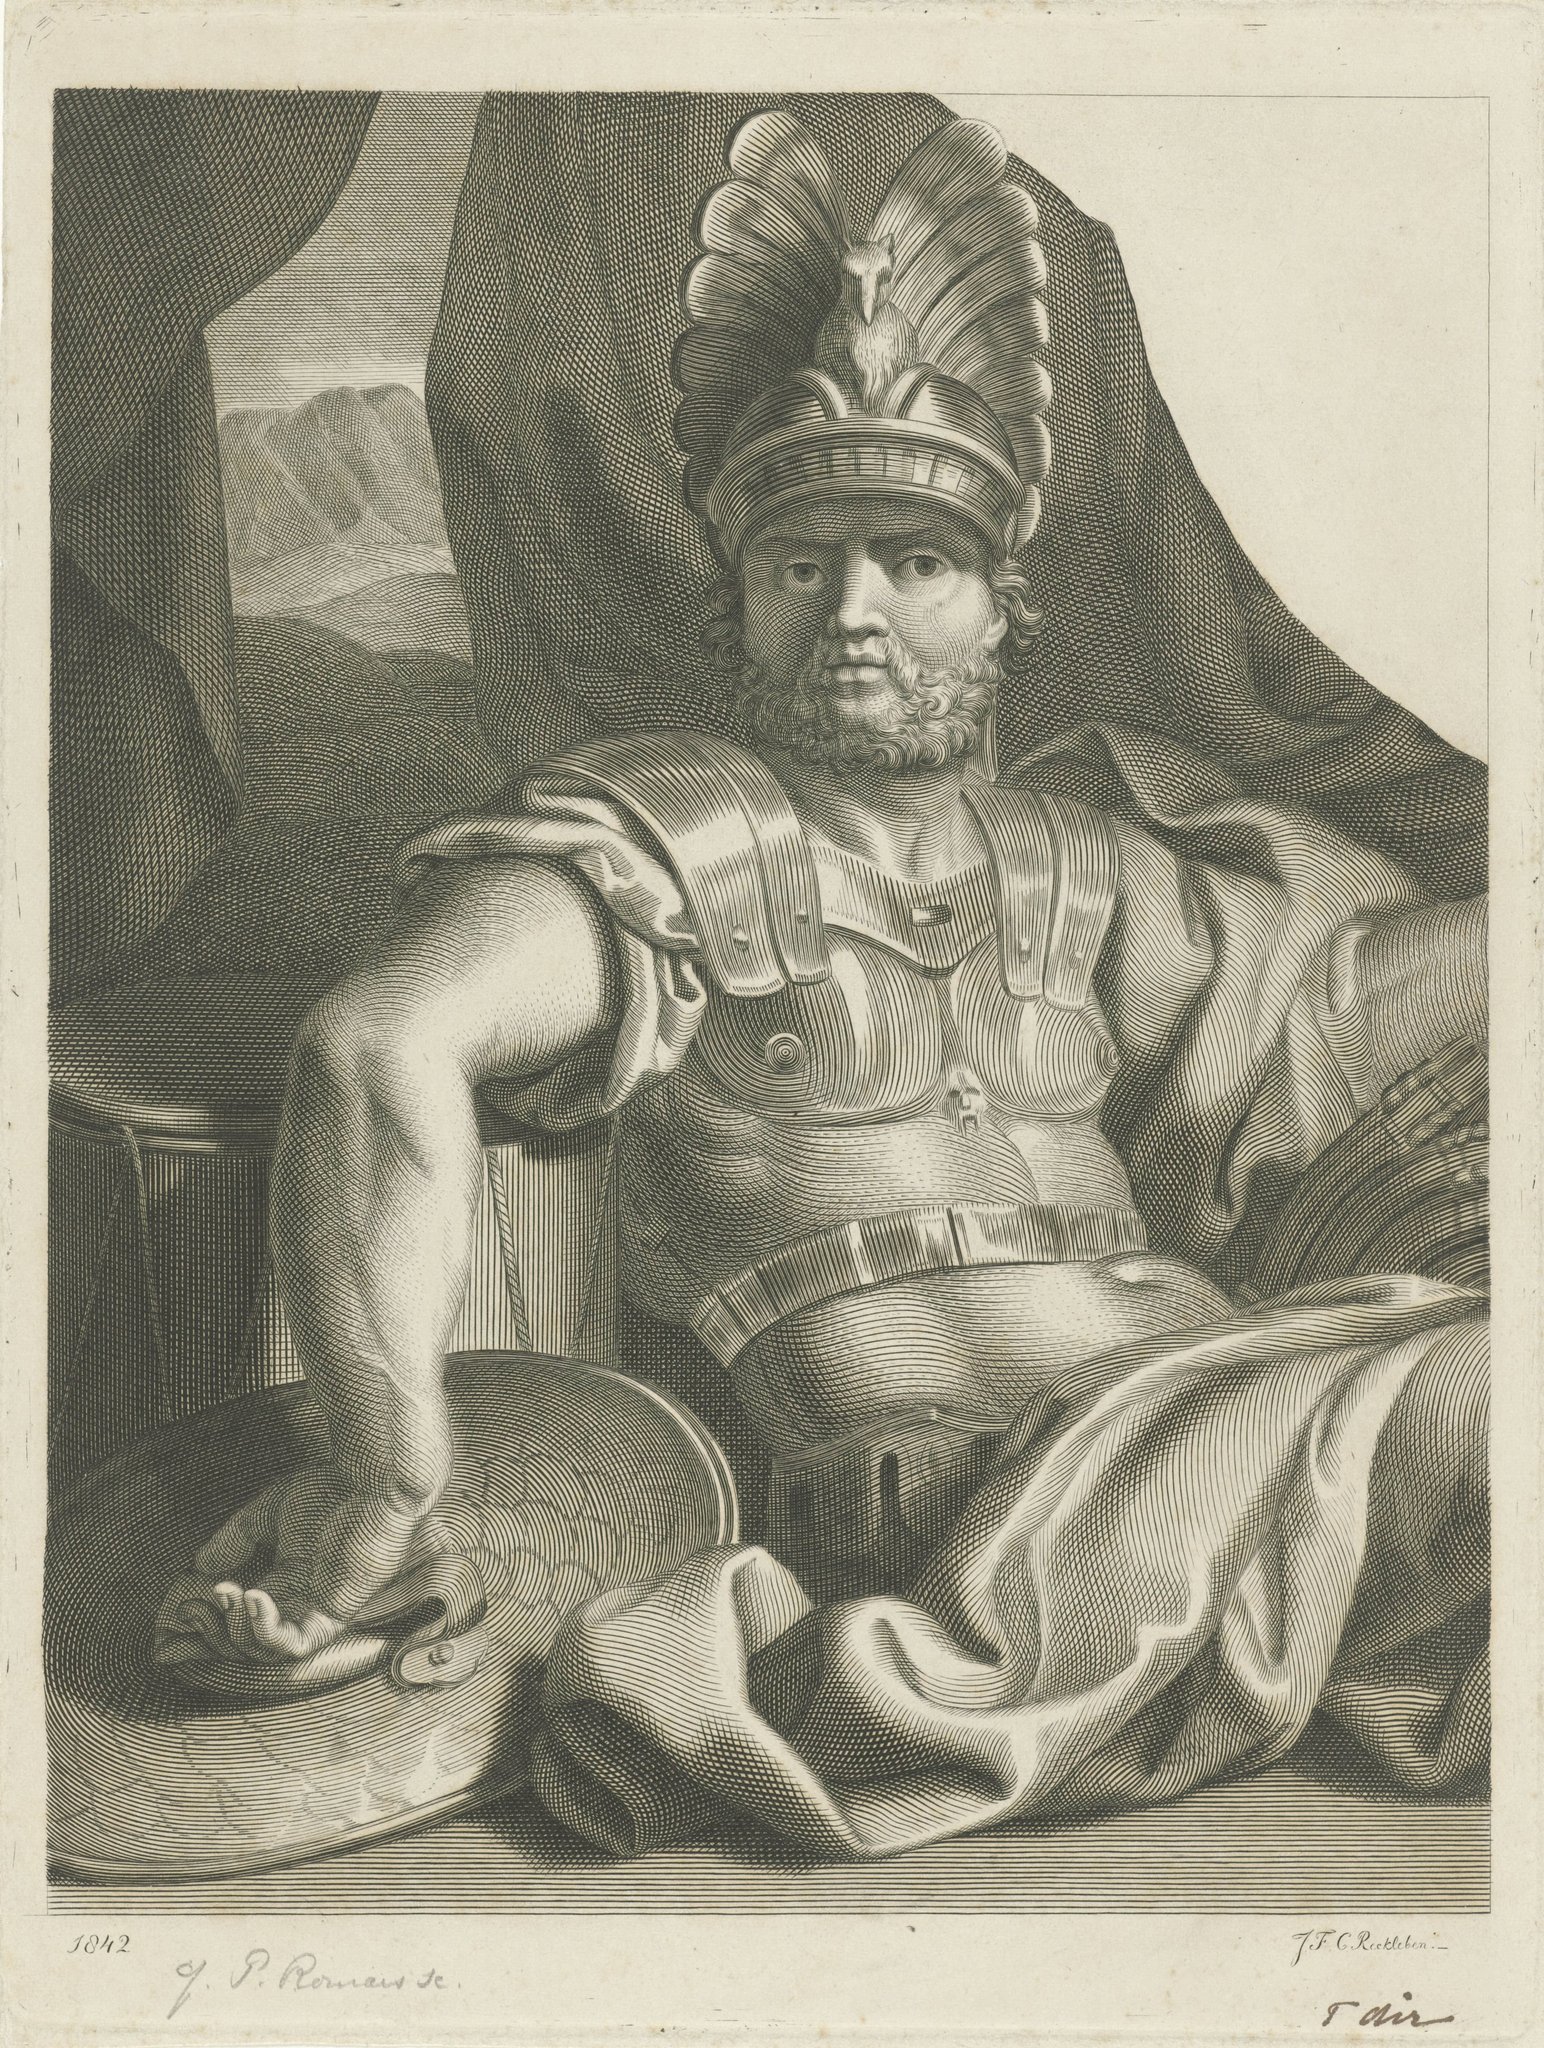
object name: print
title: Romeinse krijgsman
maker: jan frederik christiaan reckleben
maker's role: print maker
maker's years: 1819-1879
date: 1842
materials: paper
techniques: engraving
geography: amsterdam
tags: (story of) mars (ares), the soldier; the soldier's life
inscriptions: date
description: Een Romeinse krijgsman (mogelijk Mars) zit in een wapenrusting op de grond.